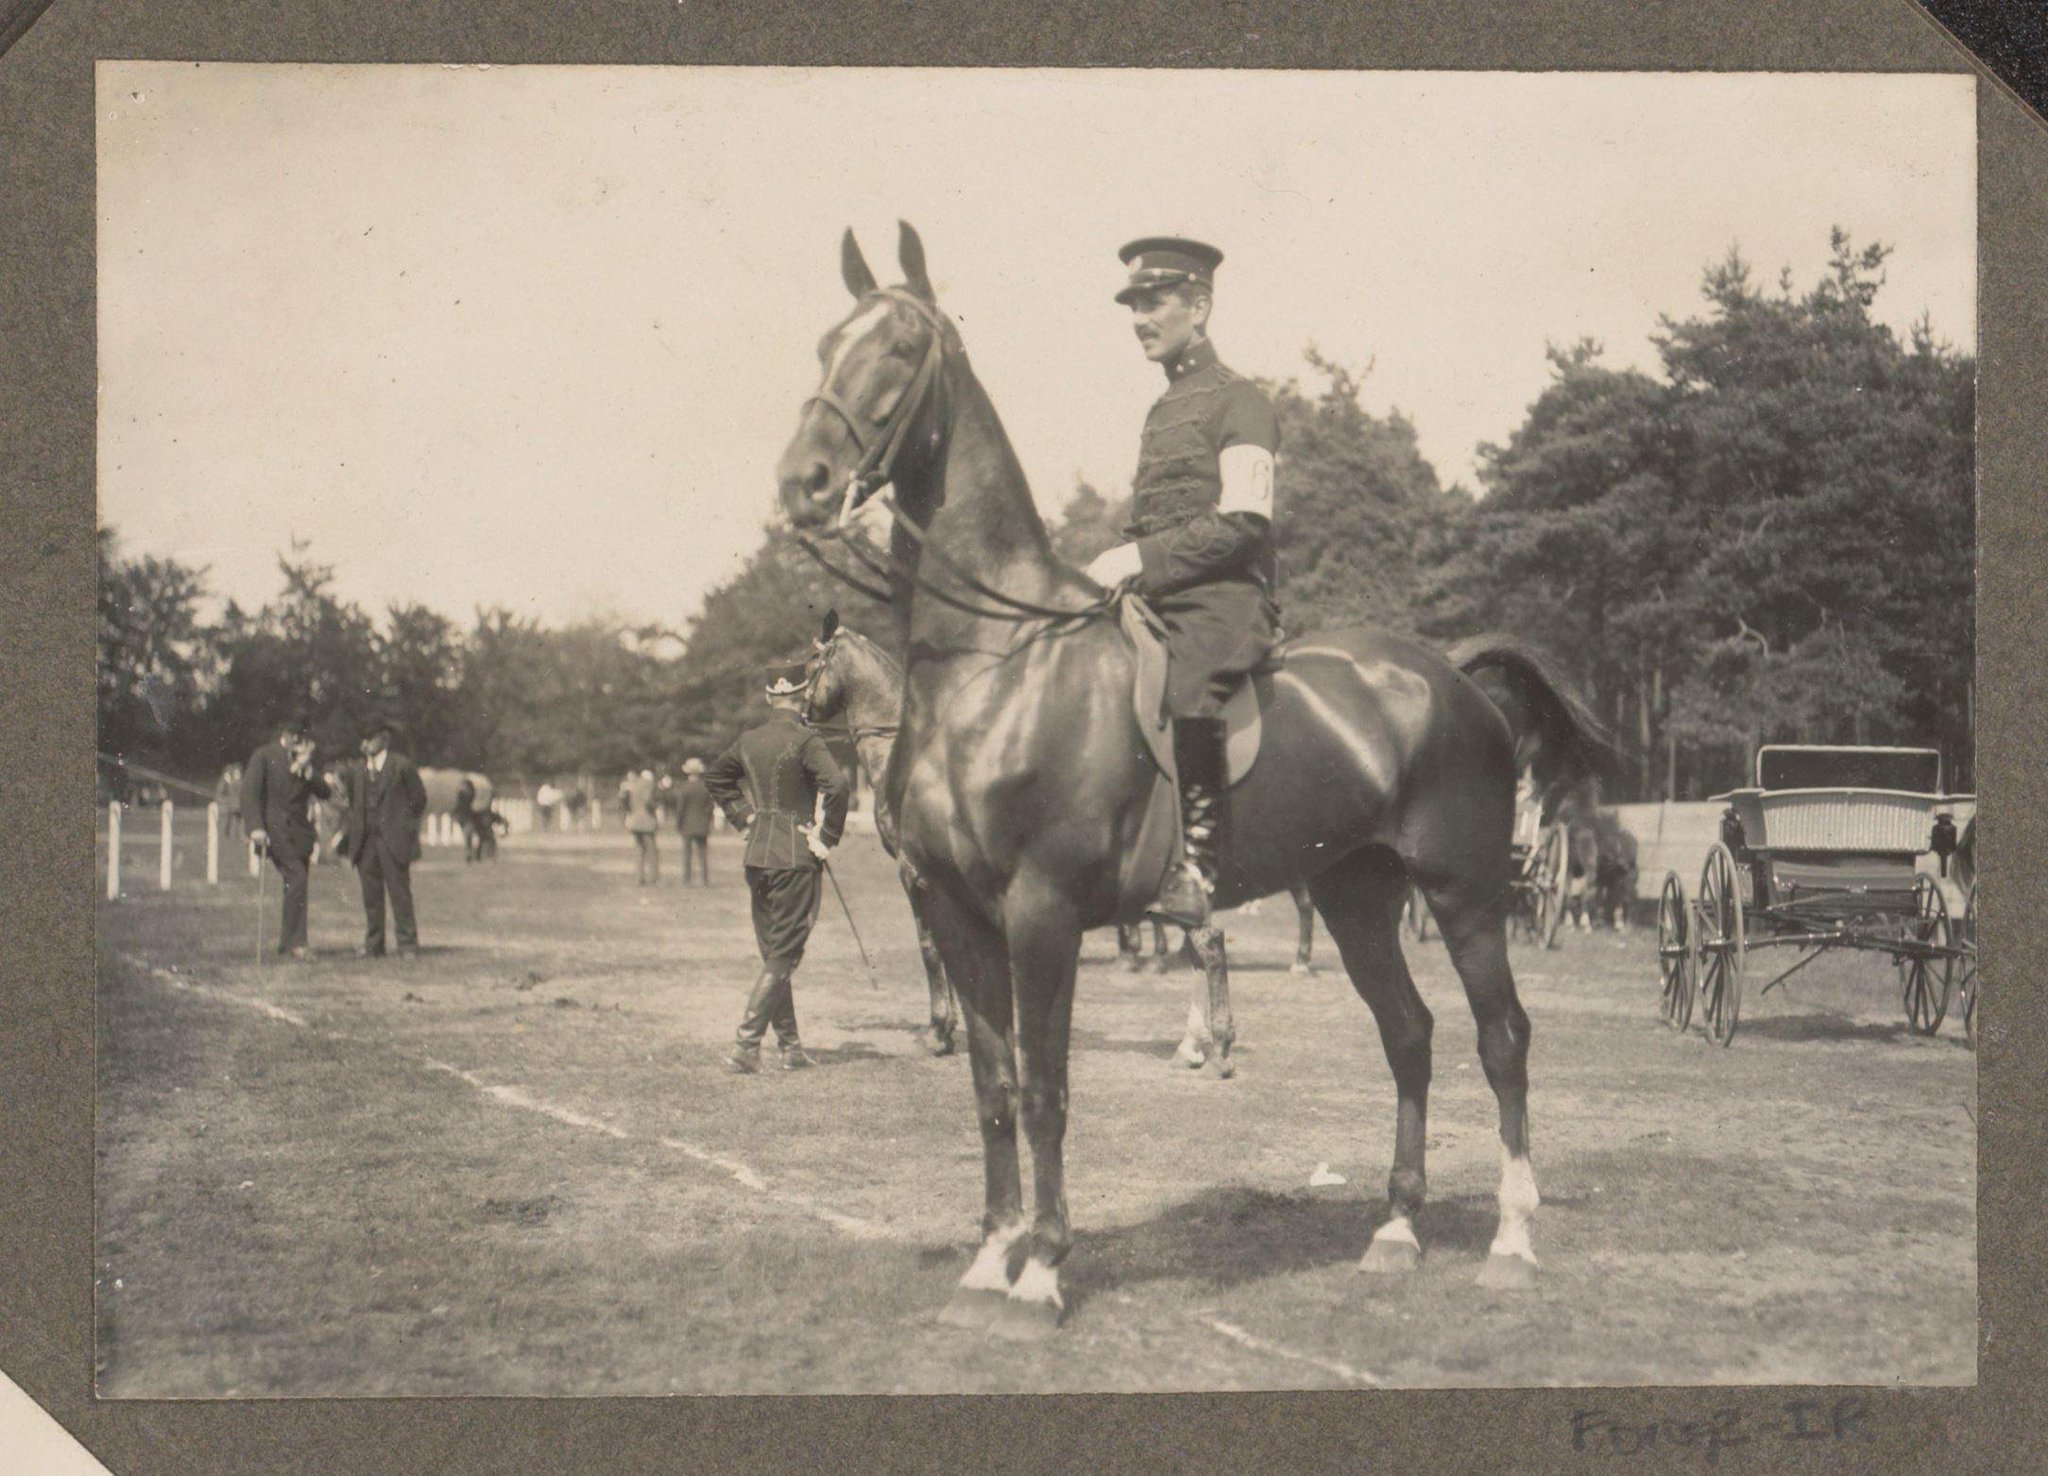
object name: photograph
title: Ruitertafereel op Koninklijke Houtvesterij Het Loo: geüniformeerde man te paard op een grasveld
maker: Anonymous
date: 1900-1925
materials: photographic support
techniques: gelatin silver print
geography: het loo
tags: riding a horse, ass, or mule; rider, horseman, hunting, chase, hunting-ground, (military) uniforms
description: Onderdeel van Fotoalbum van de heer Brams, opperhoutvester van koningin Wilhelmina op Koninklijke Houtvesterij Het Loo.